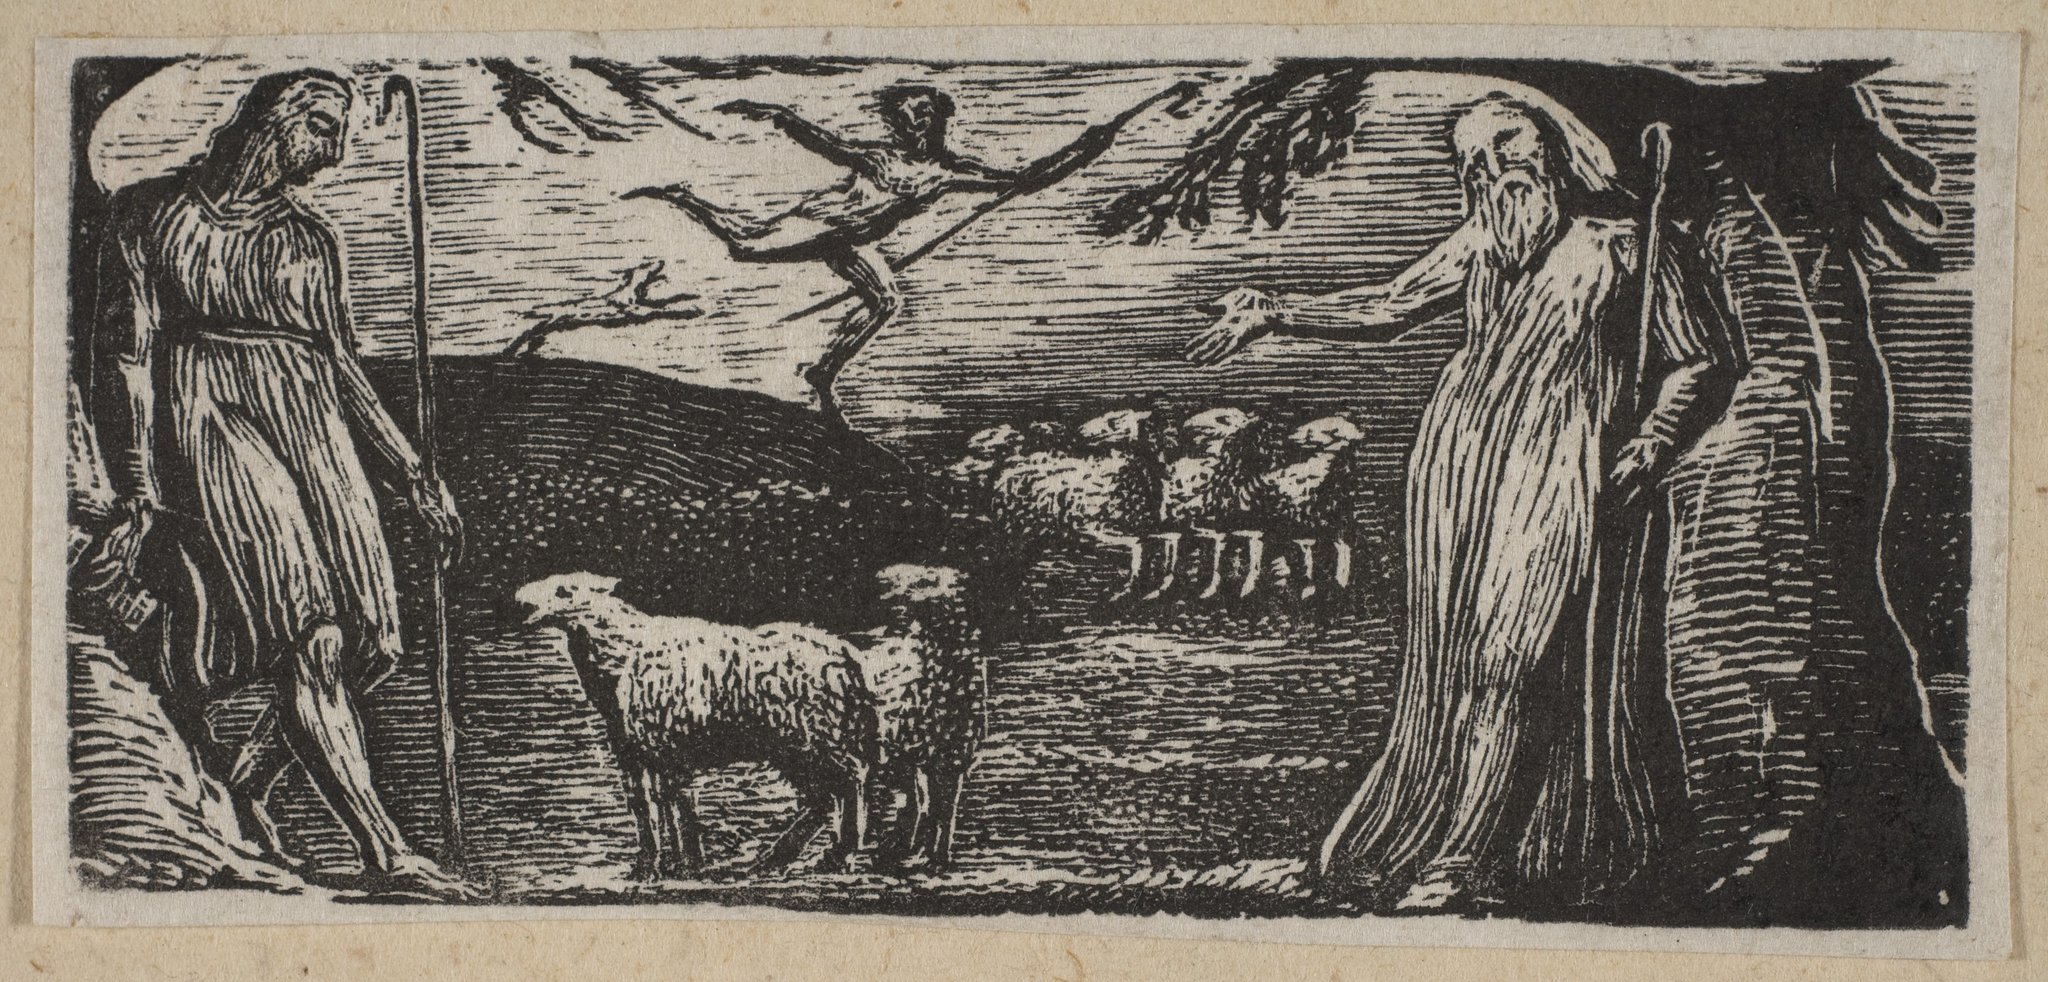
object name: print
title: Thenot Remonstrates with Colinet, Lightfoot in the Background, from Thornton's "Pastorals of Virgil"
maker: william blake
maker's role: artist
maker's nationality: british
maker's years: 1757-1827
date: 1821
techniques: engraving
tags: men,sheep